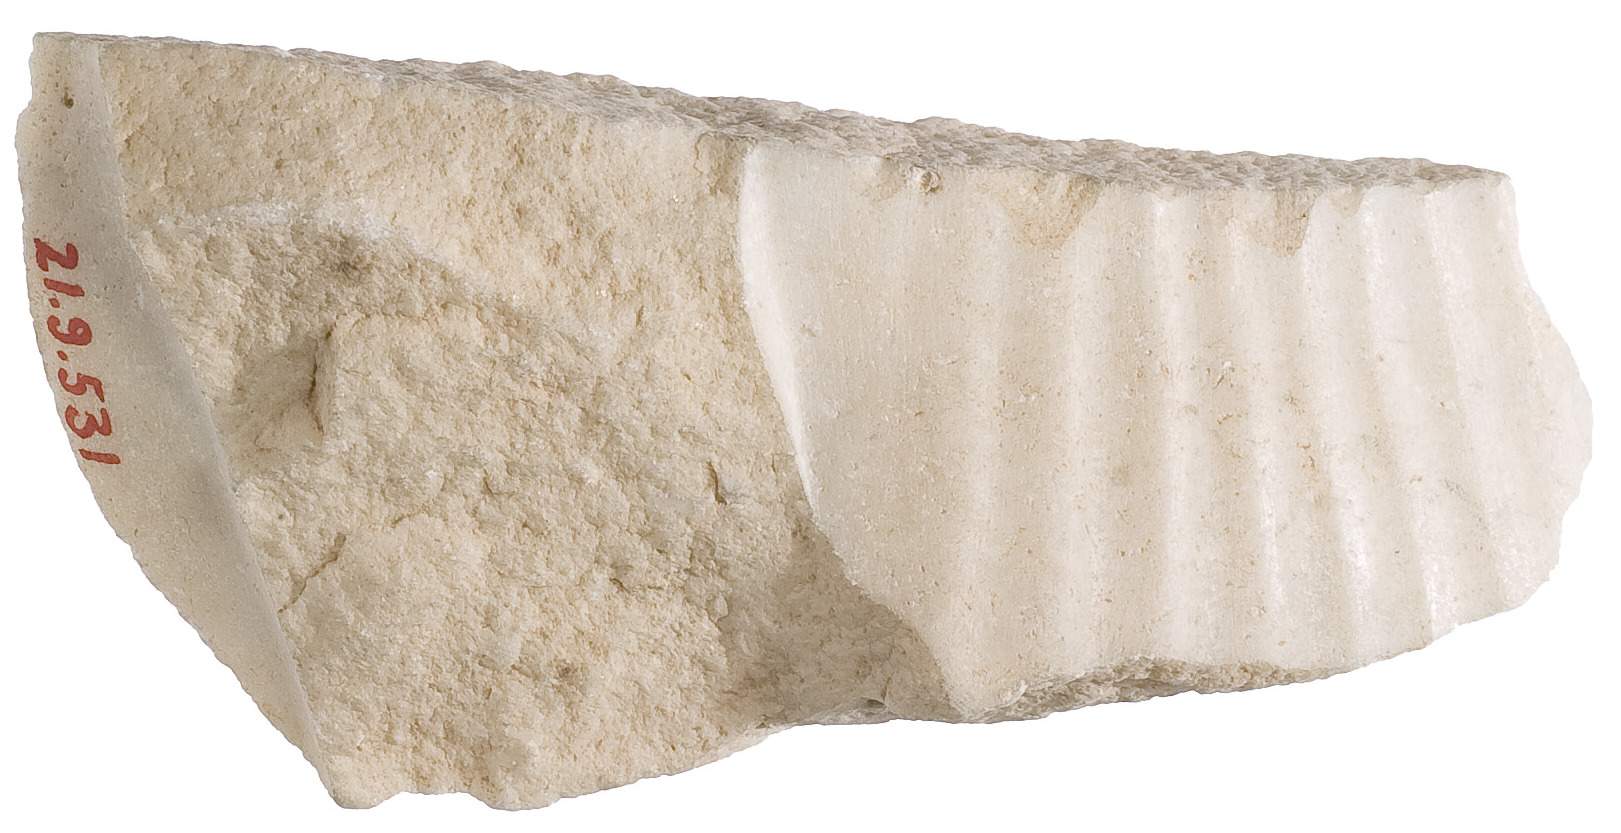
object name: body with garment, pleating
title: Side of body in pleated dress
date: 1353-1336 BCE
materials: limestone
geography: egypt